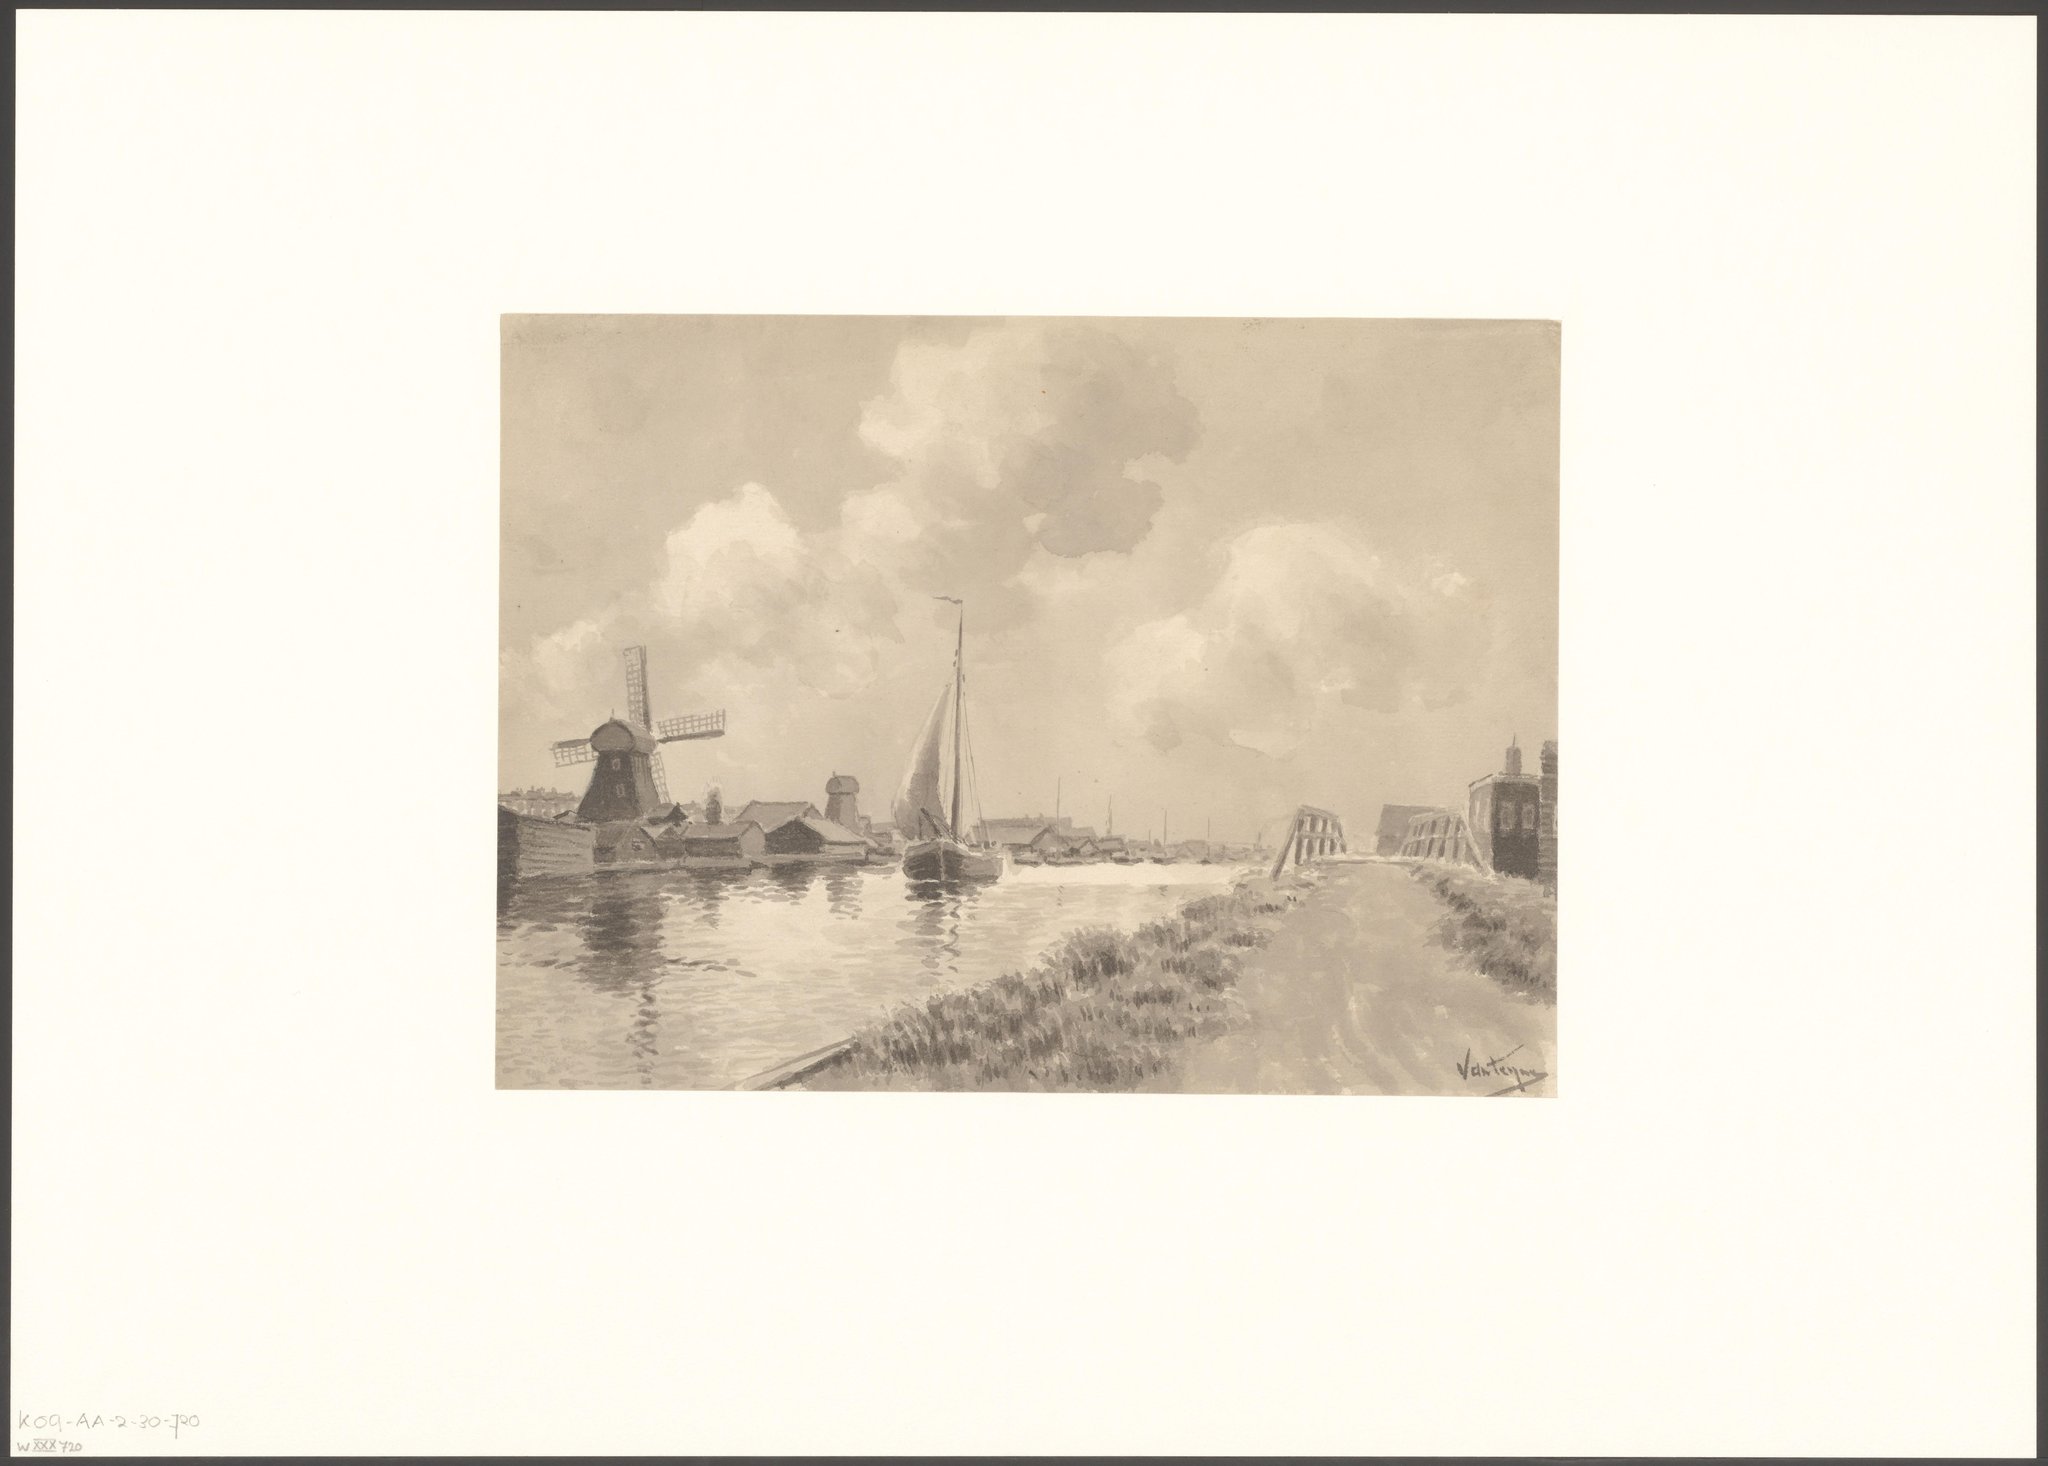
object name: drawing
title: Gezicht op de Kostverlorenvaart vanaf de Buyskade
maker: anthonie van teijn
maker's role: draughtsman, painter, print maker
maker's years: 1863-1943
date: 1907-1927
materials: ink, paper, pencil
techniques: brush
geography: amsterdam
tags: sailing-ship, sailing-boat, city-view in general; 'veduta', canal, windmill in landscape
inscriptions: inscription: ‘De Kostverlorenvaart gezien (...) Juli 1927. / vanEck’, collector's mark: Lugt 800a, signature: ‘VanTeyne’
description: Tekening binnen de Atlas Van Eck ingedeeld op wijknummer 30.